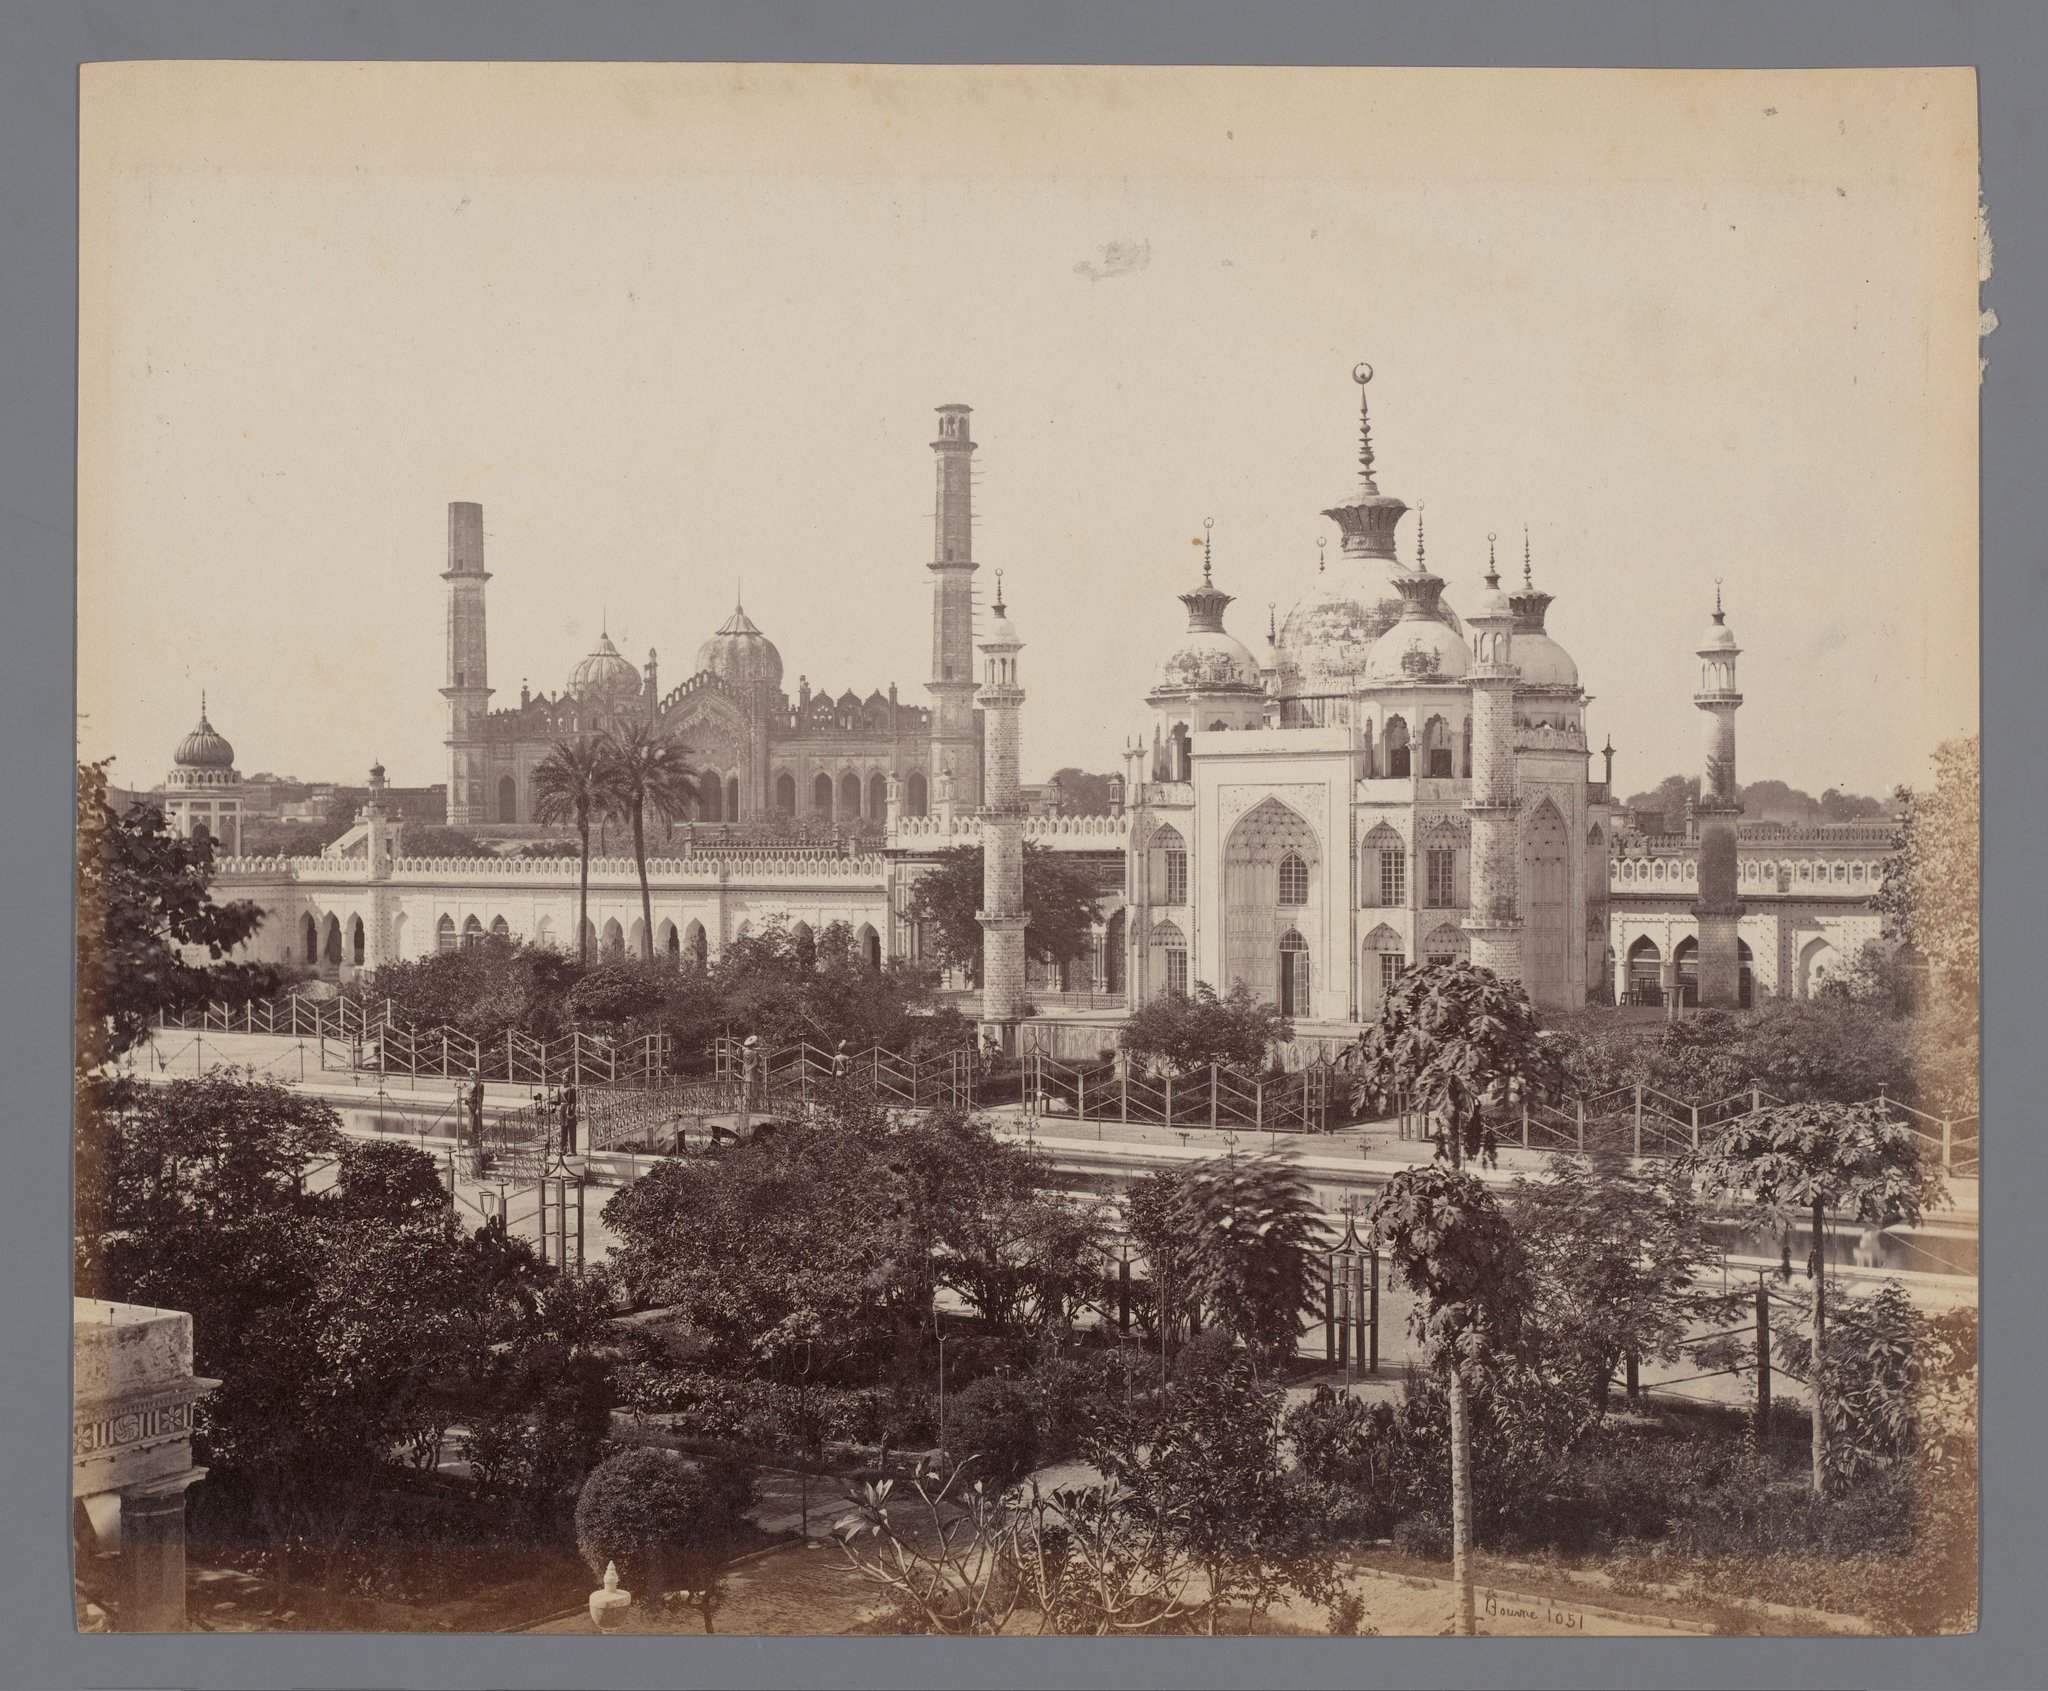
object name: photograph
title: View of mosques in Lucknow, Uttar Pradesh, India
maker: samuel bourne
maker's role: fotograaf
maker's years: 1834-1912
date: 1863-1868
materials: paper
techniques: albumen print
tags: lucknow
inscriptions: signature: ‘Bourne 1051’, inscription: ‘Lucknow’, number: ‘35’